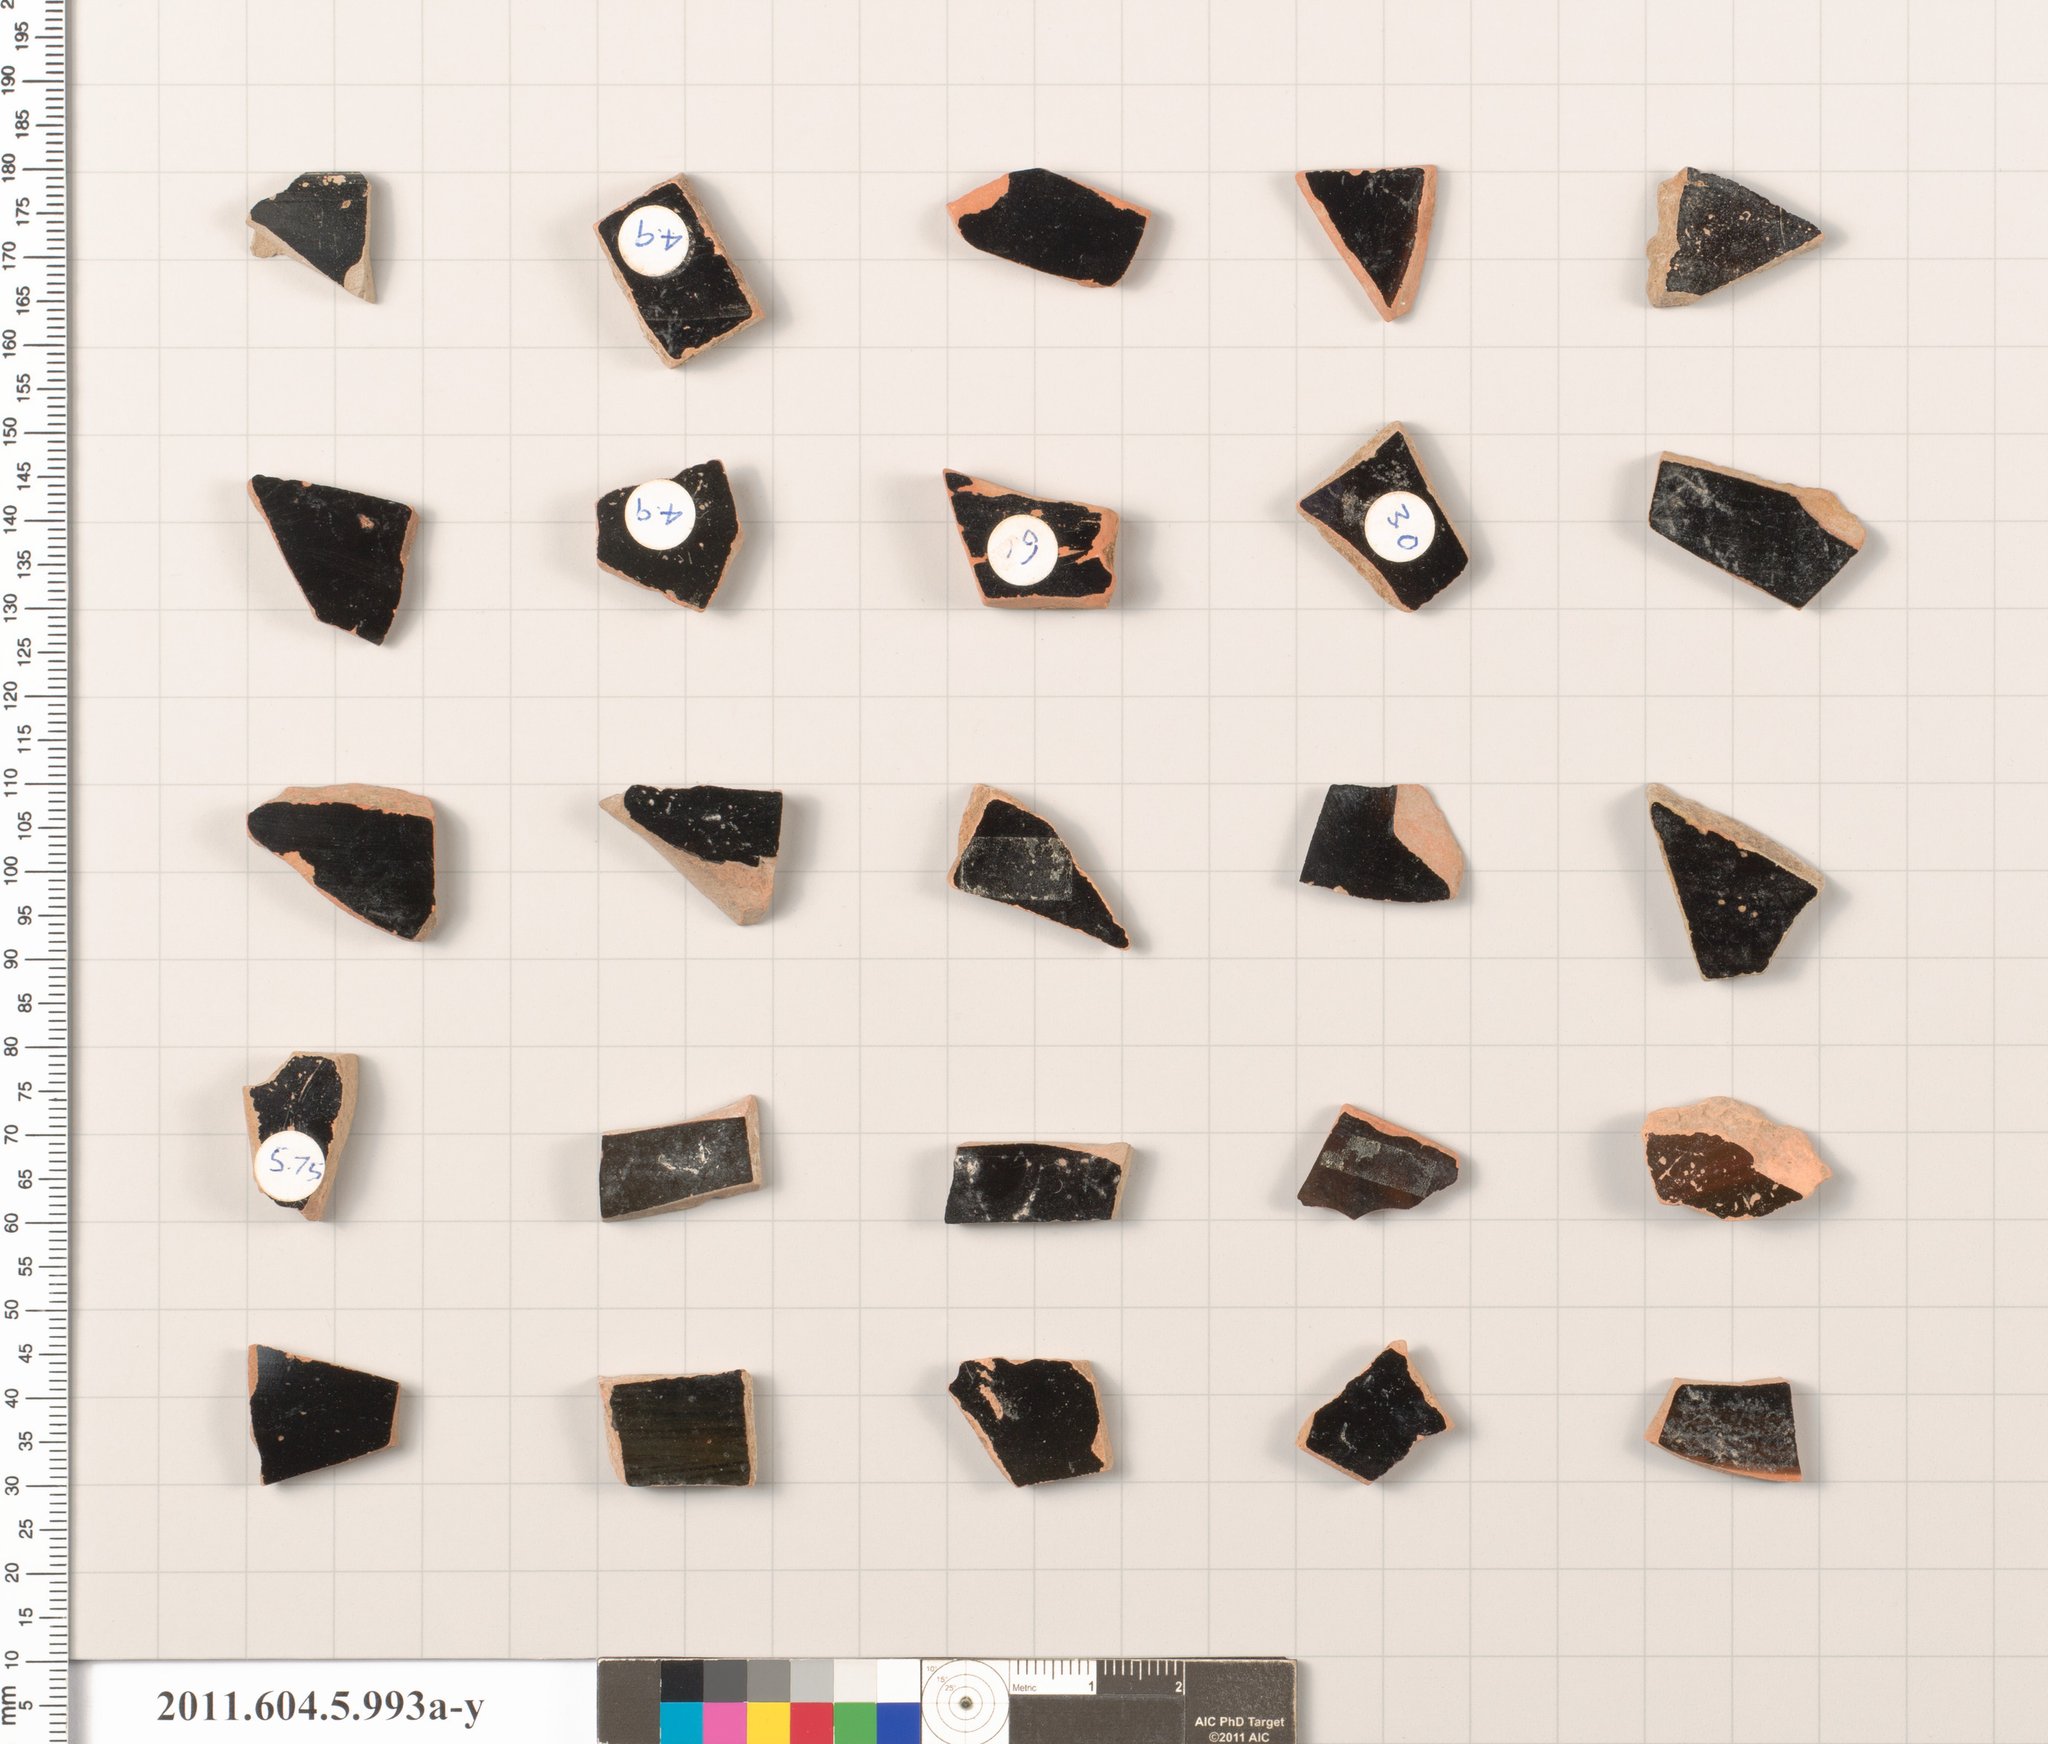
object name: kylix fragment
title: Terracotta fragments of kylikes (drinking cups)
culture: greek, attic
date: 600-401 BCE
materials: terracotta